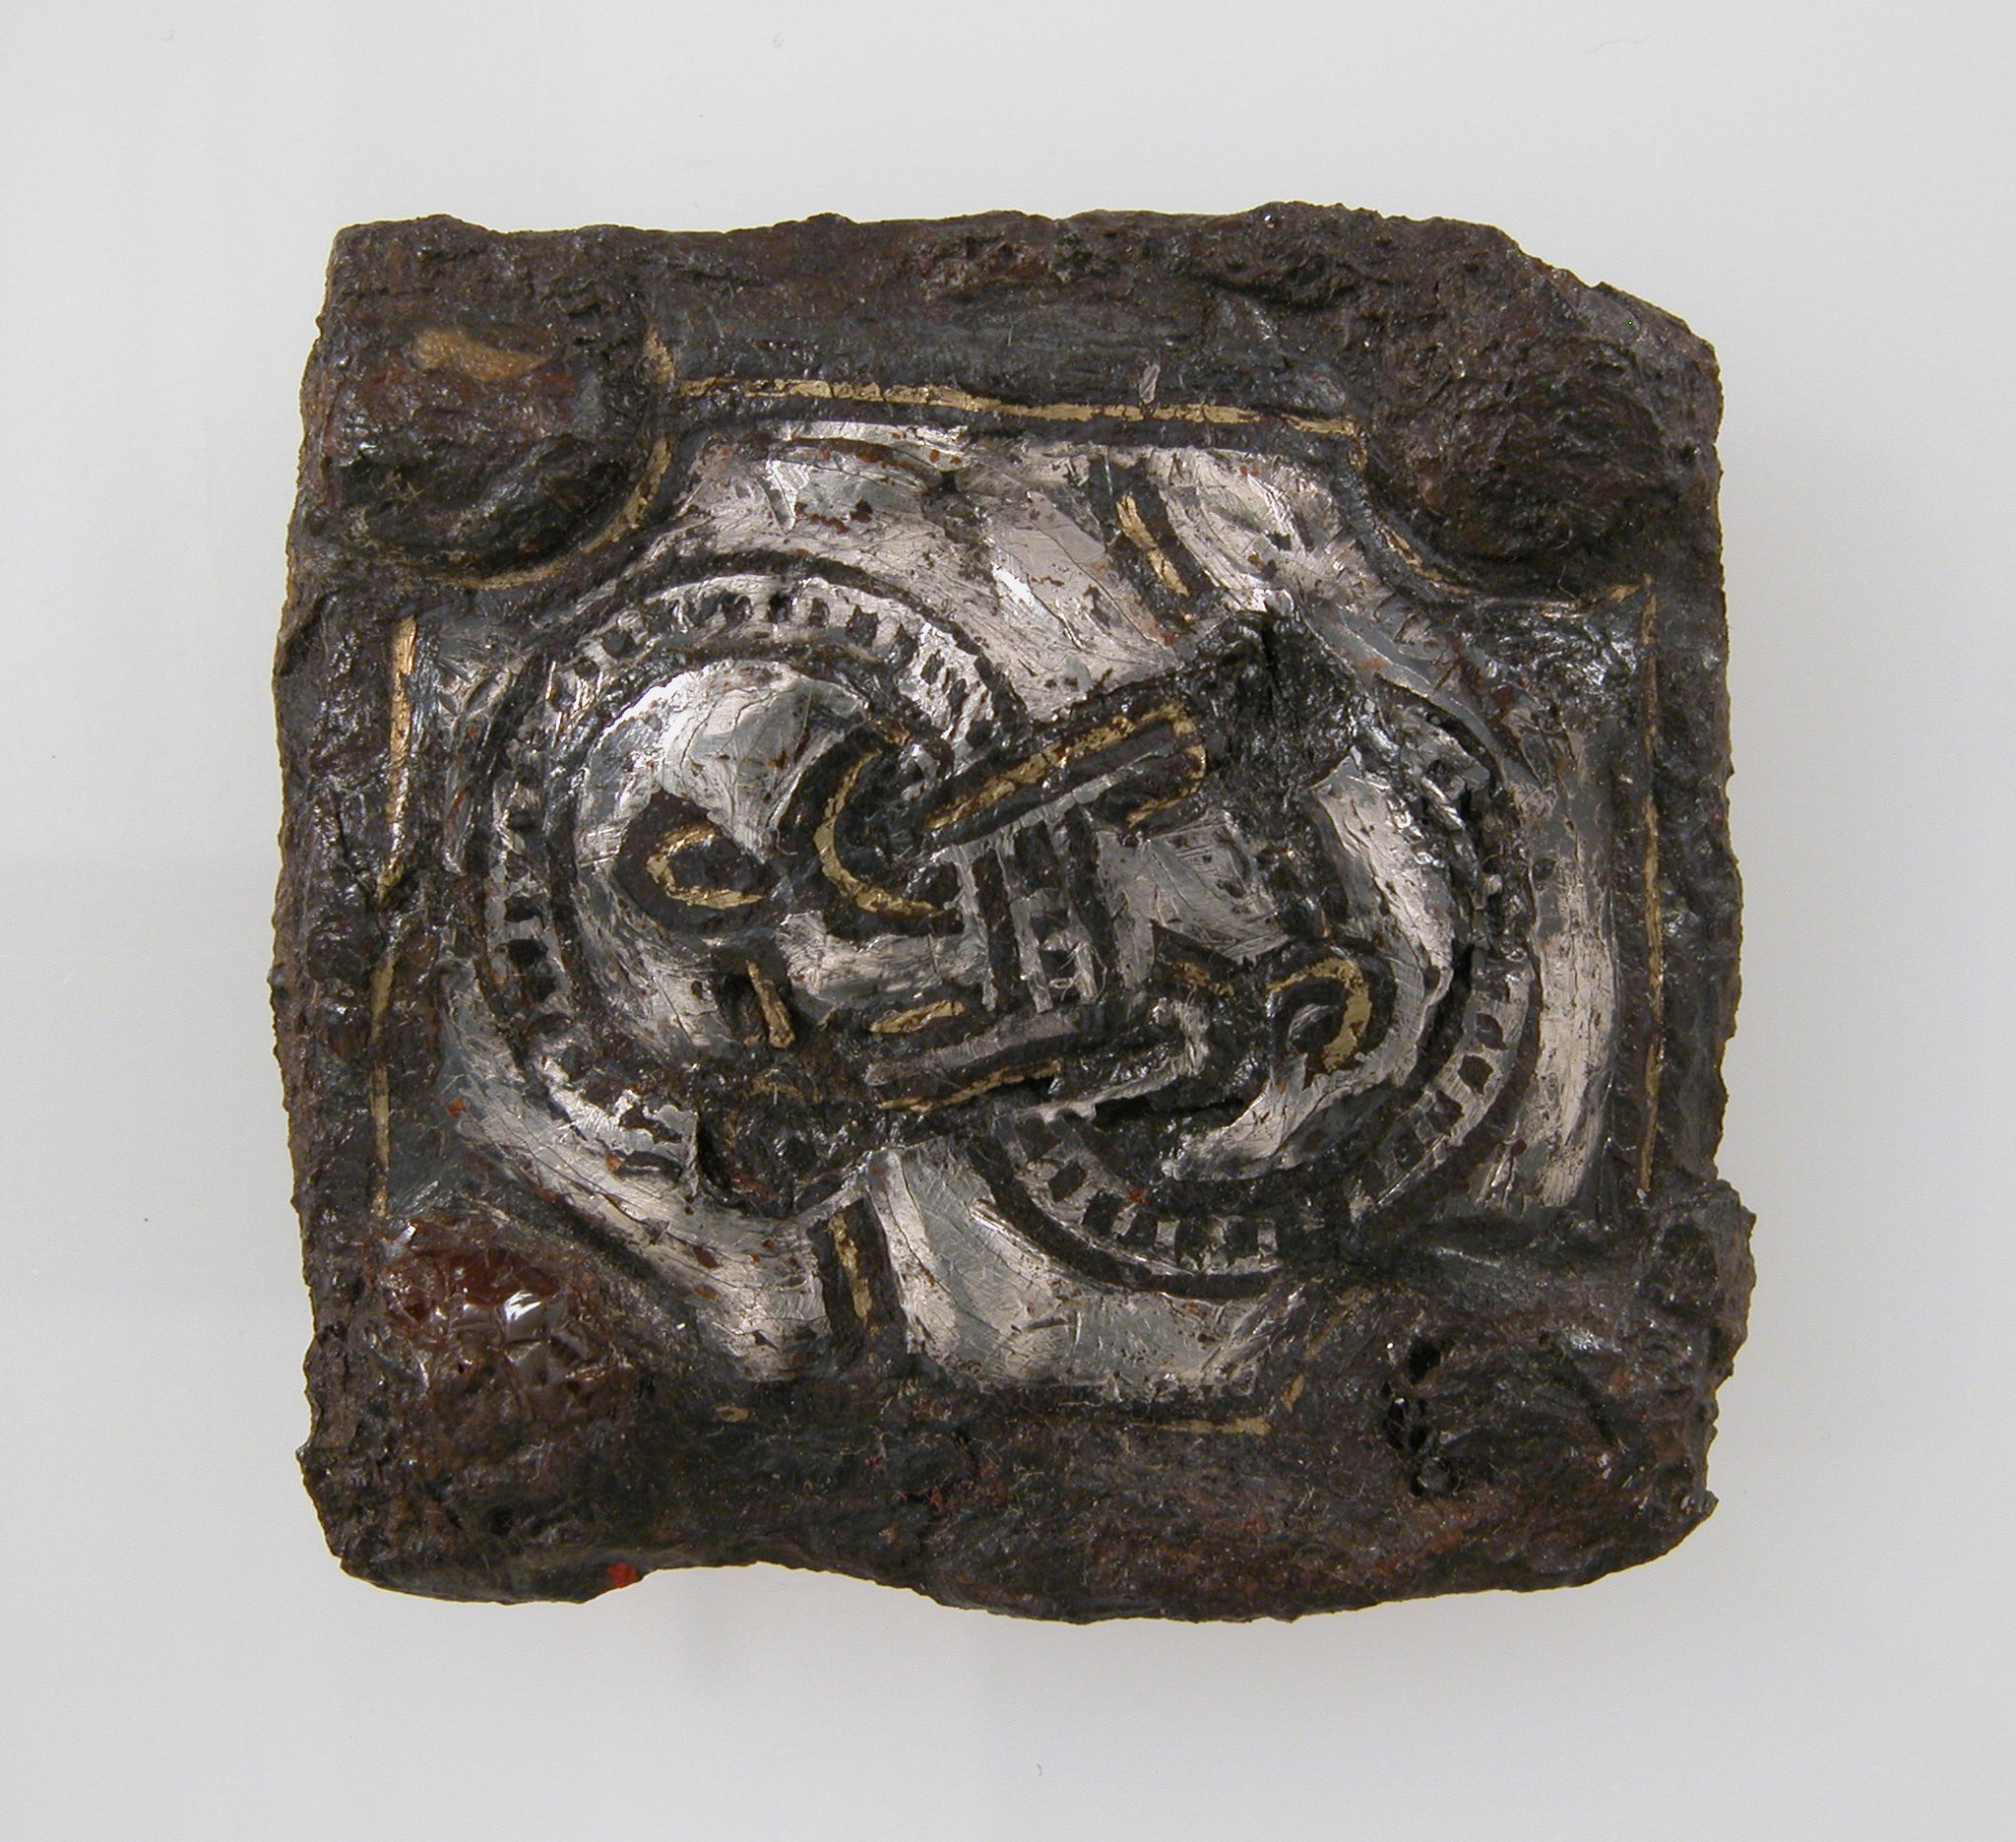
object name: belt plate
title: Plate of a Belt Buckle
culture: frankish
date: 501-700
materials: brass, iron, silver